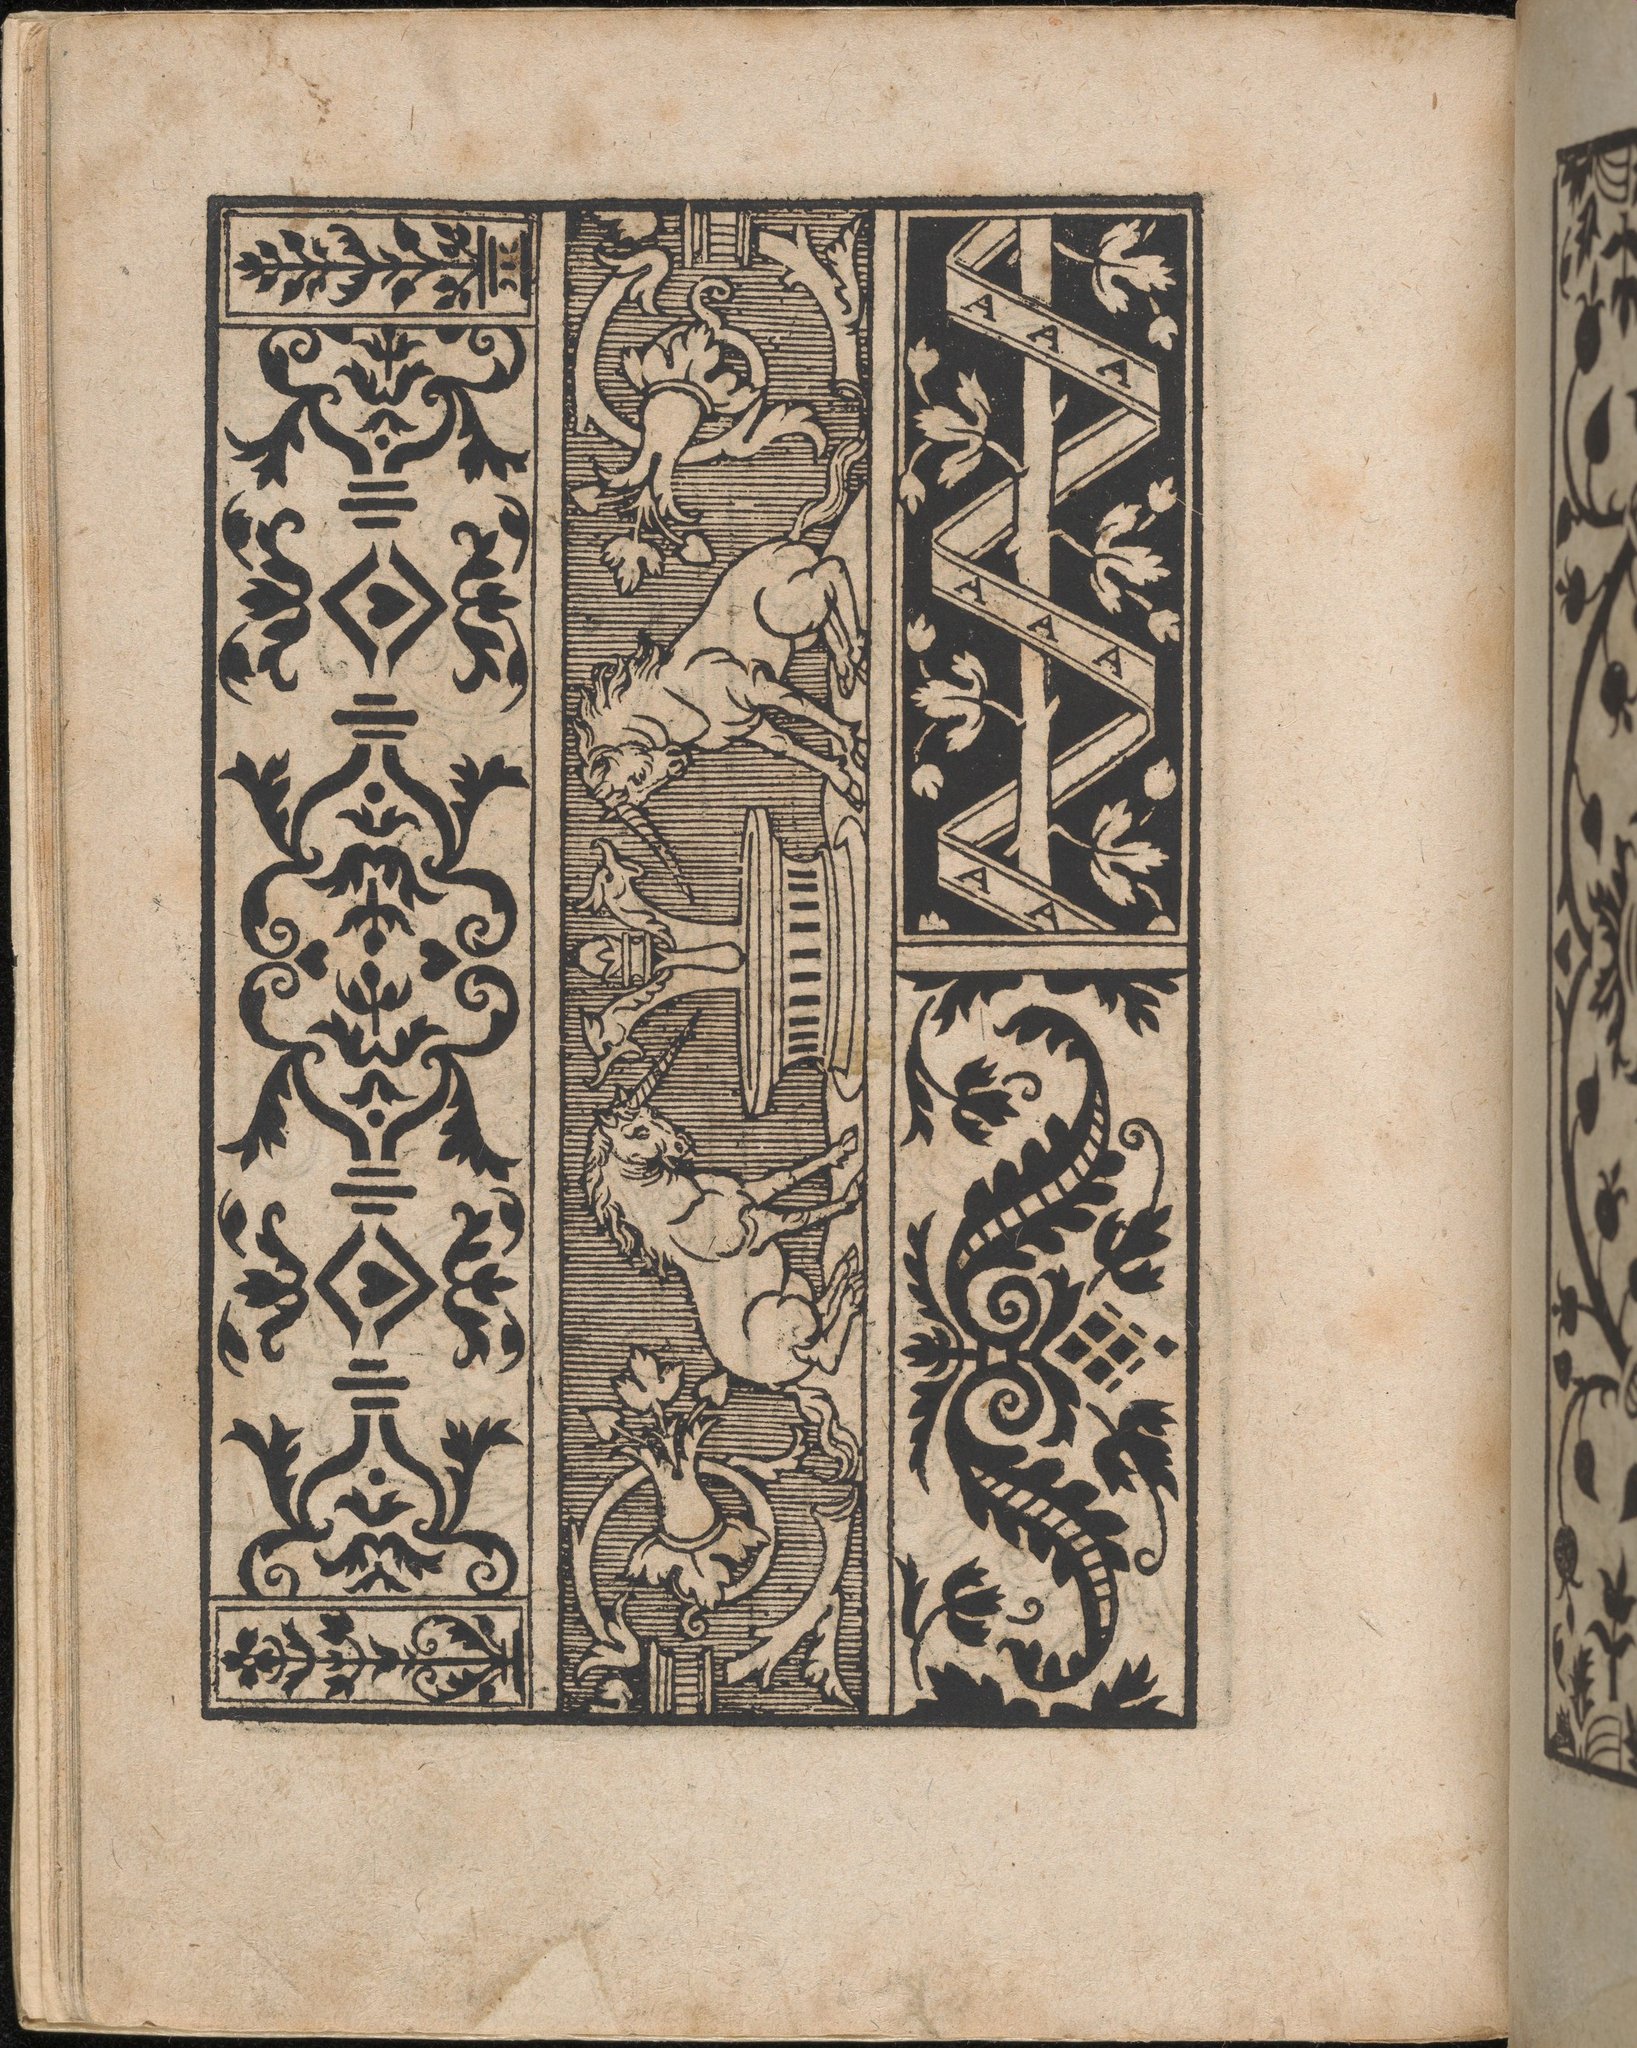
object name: book print ornament architecture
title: Ein new Modelbuch..., page 11 (verso)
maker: johann schönsperger the younger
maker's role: publisher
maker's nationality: german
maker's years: 1490-1550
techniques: woodcut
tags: fountains,unicorns